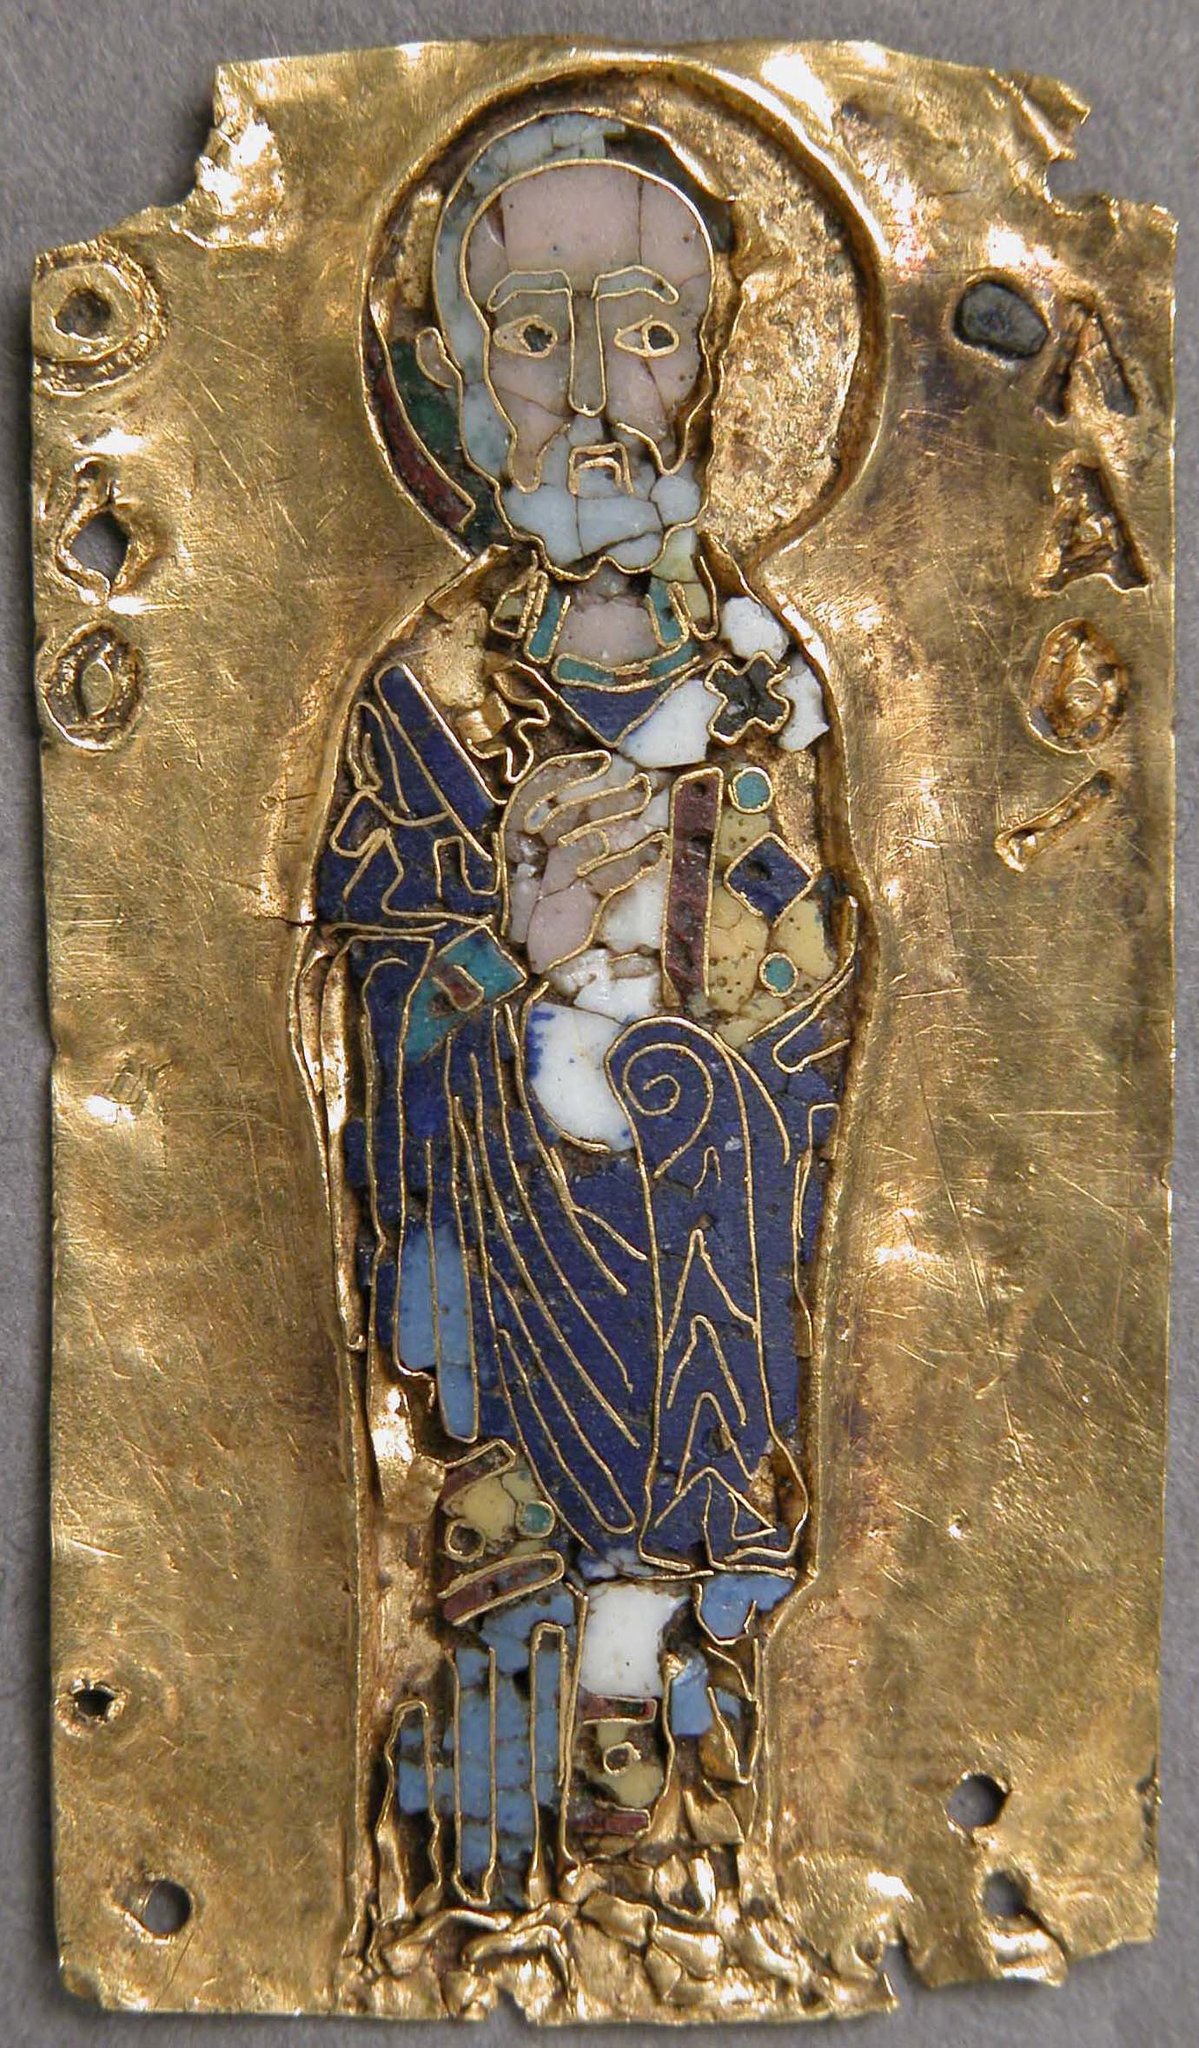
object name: medallion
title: Medallion of St. Nicholas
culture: byzantine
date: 1001-1100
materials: enamel, gold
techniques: enamel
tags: men,saints